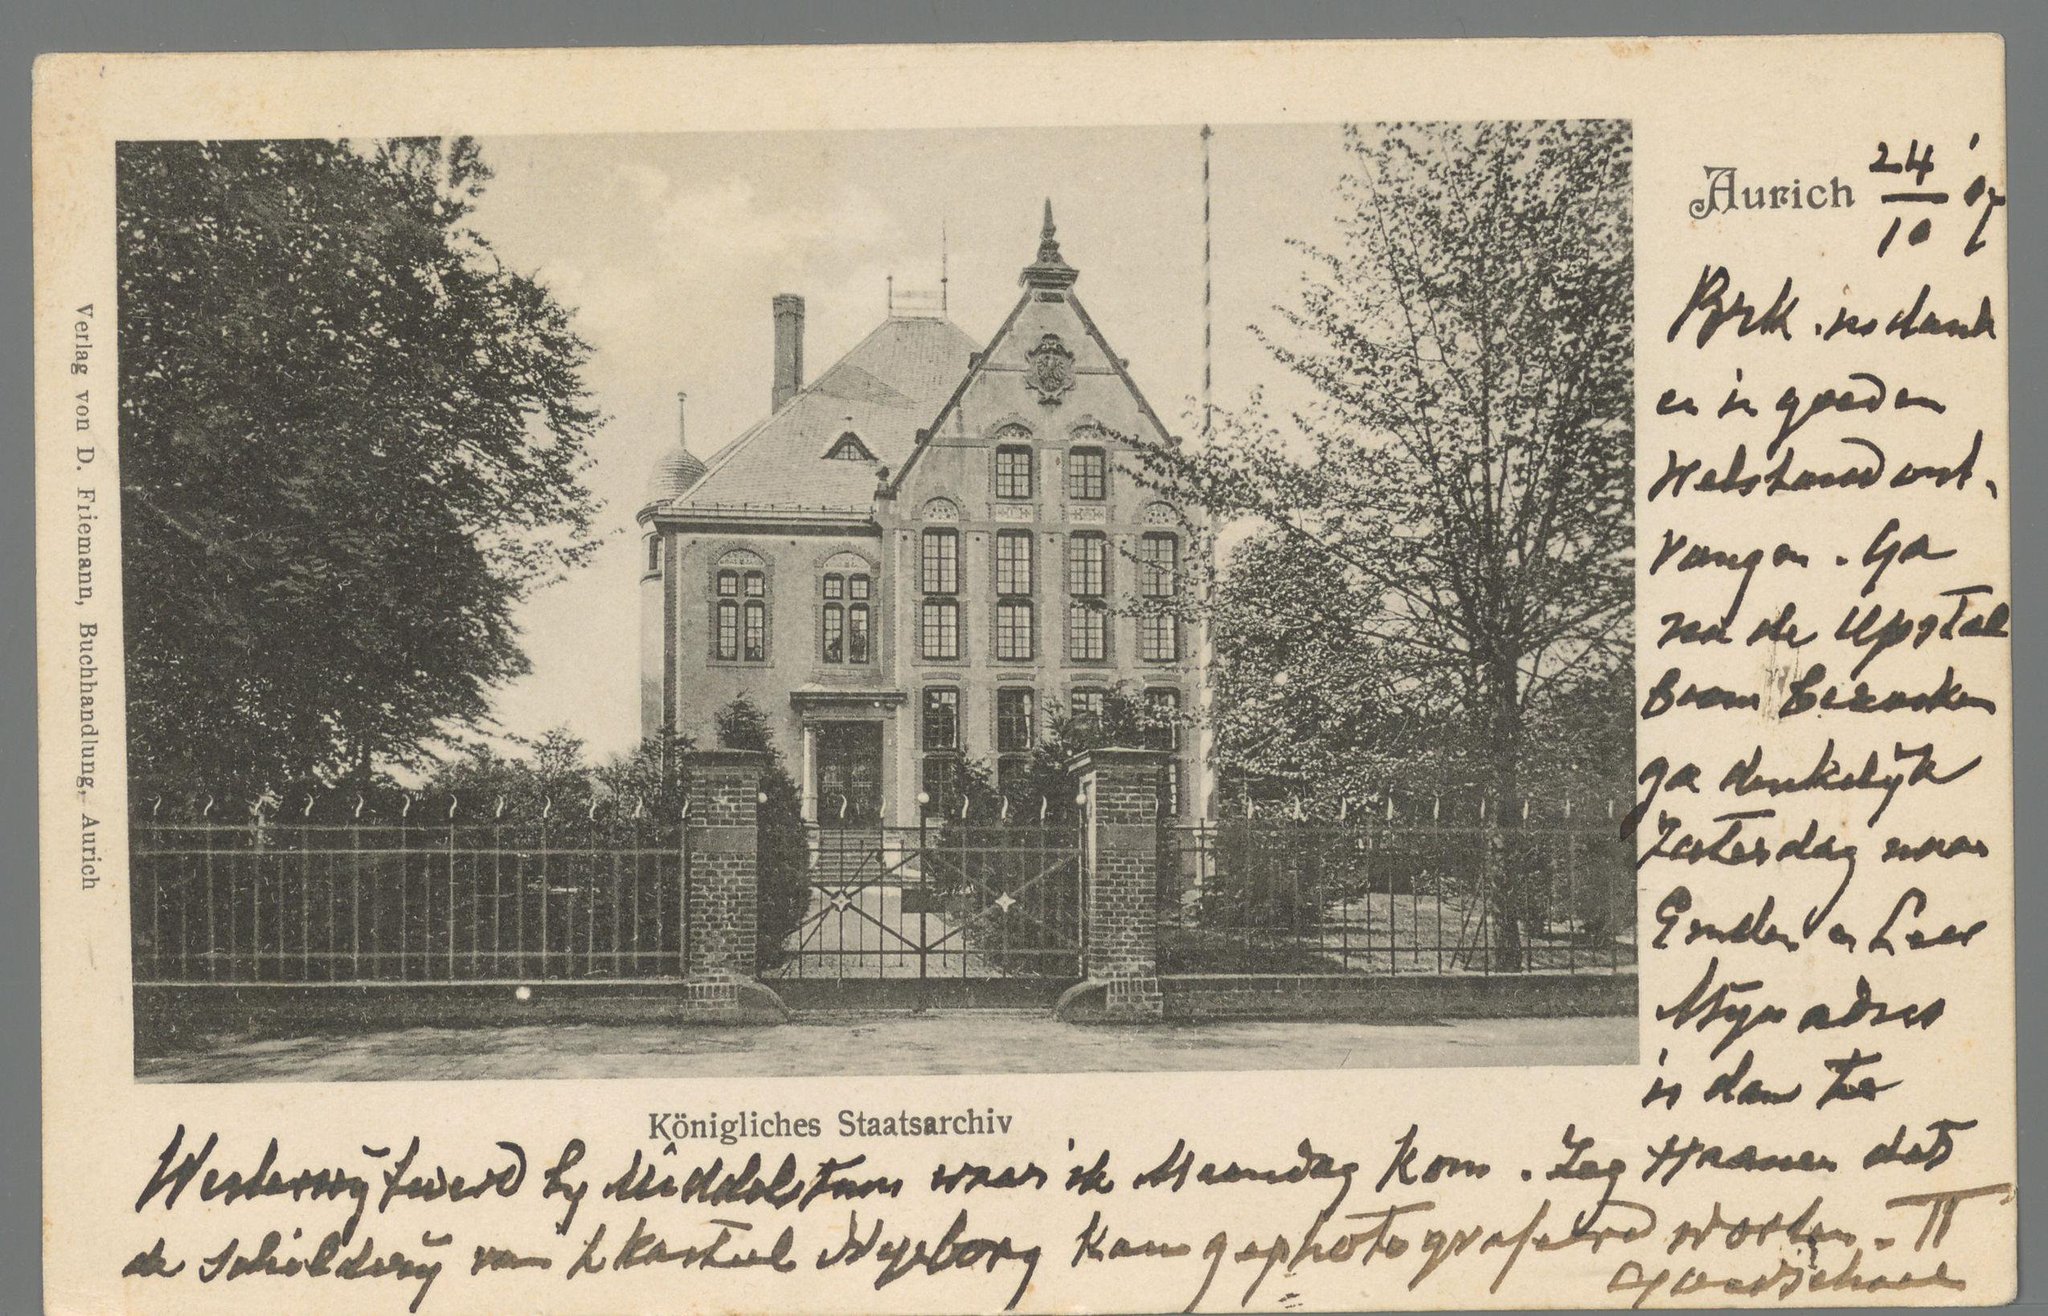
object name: photomechanical print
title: Aurich. Königliches Staatsarchiv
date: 1885-1905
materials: cardboard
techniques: photograph, writing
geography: aurich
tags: archive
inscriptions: postage stamp